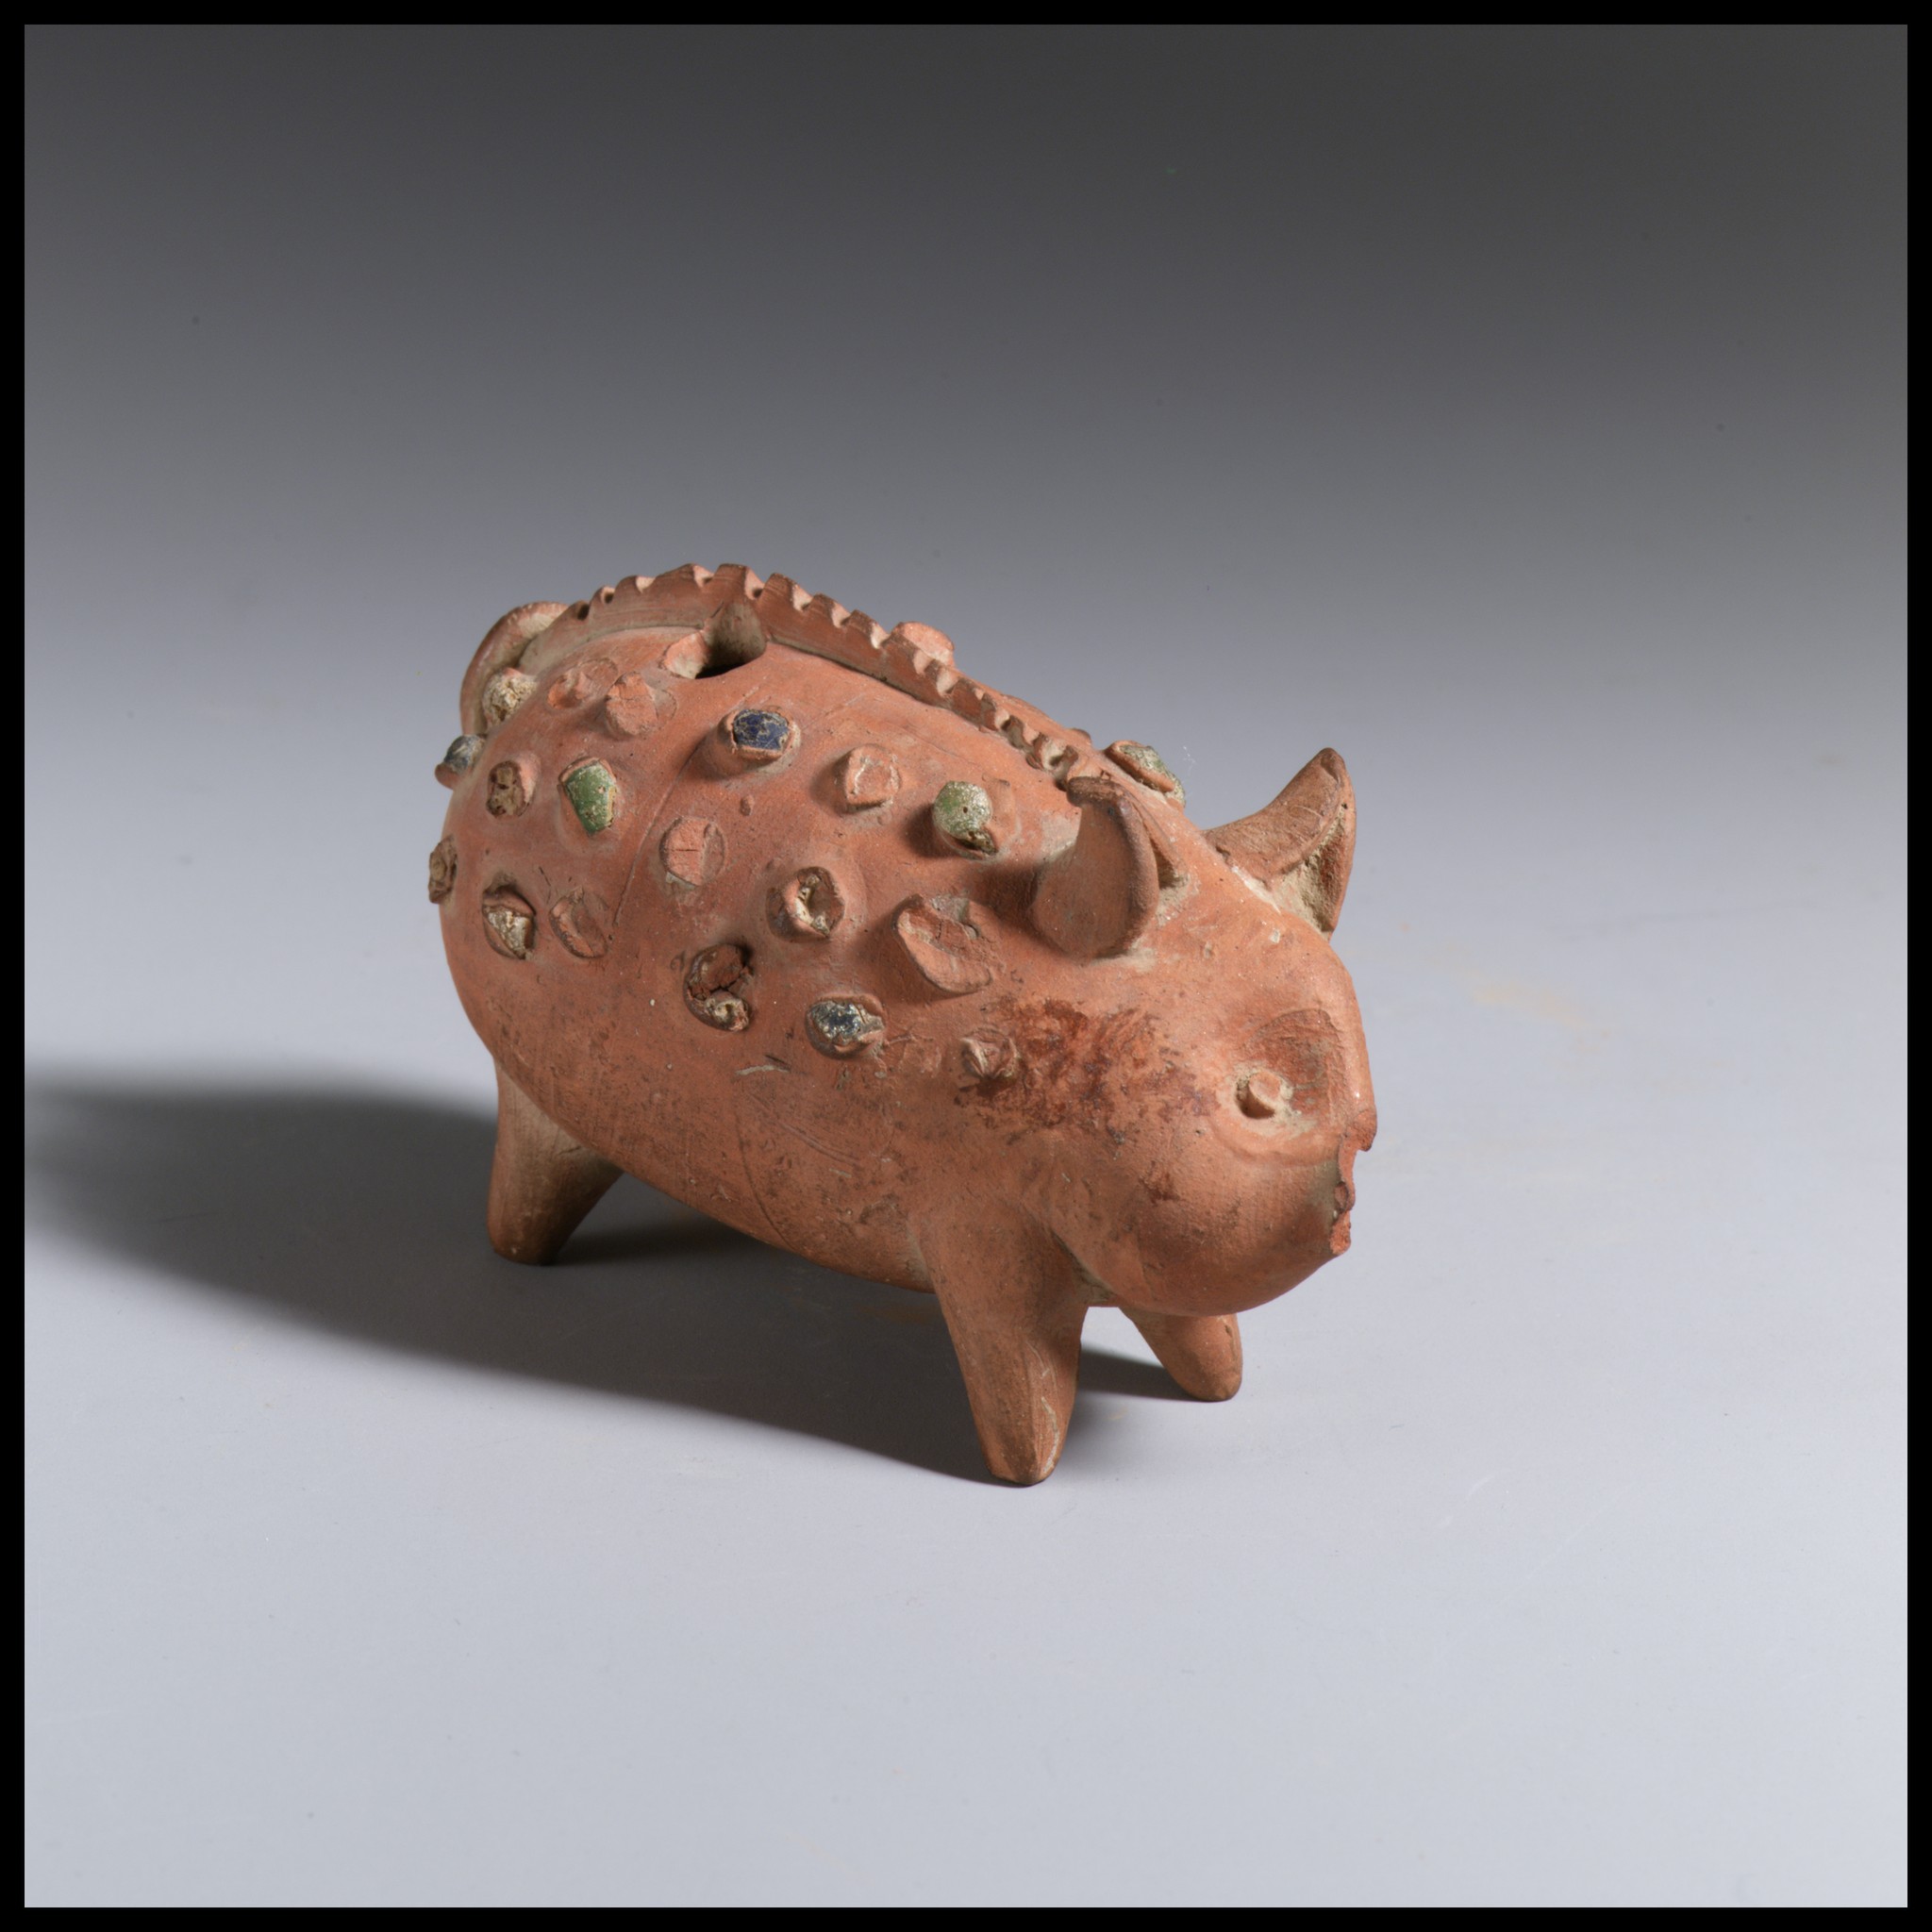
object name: rattle in the form of a pig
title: Terracotta rattle in the form of a pig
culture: roman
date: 101-200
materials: glass, terracotta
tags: pigs